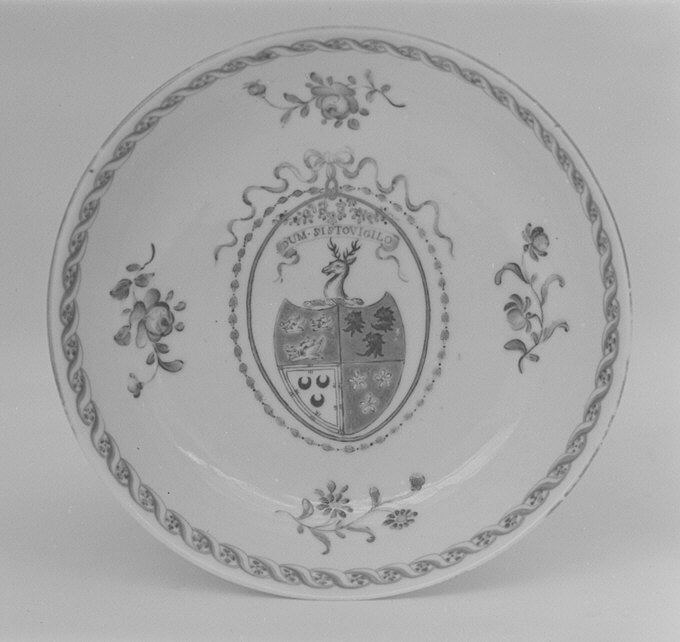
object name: saucer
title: Saucer (part of a service)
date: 1770-1785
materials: hard paste porcelain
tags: flowers,insignia